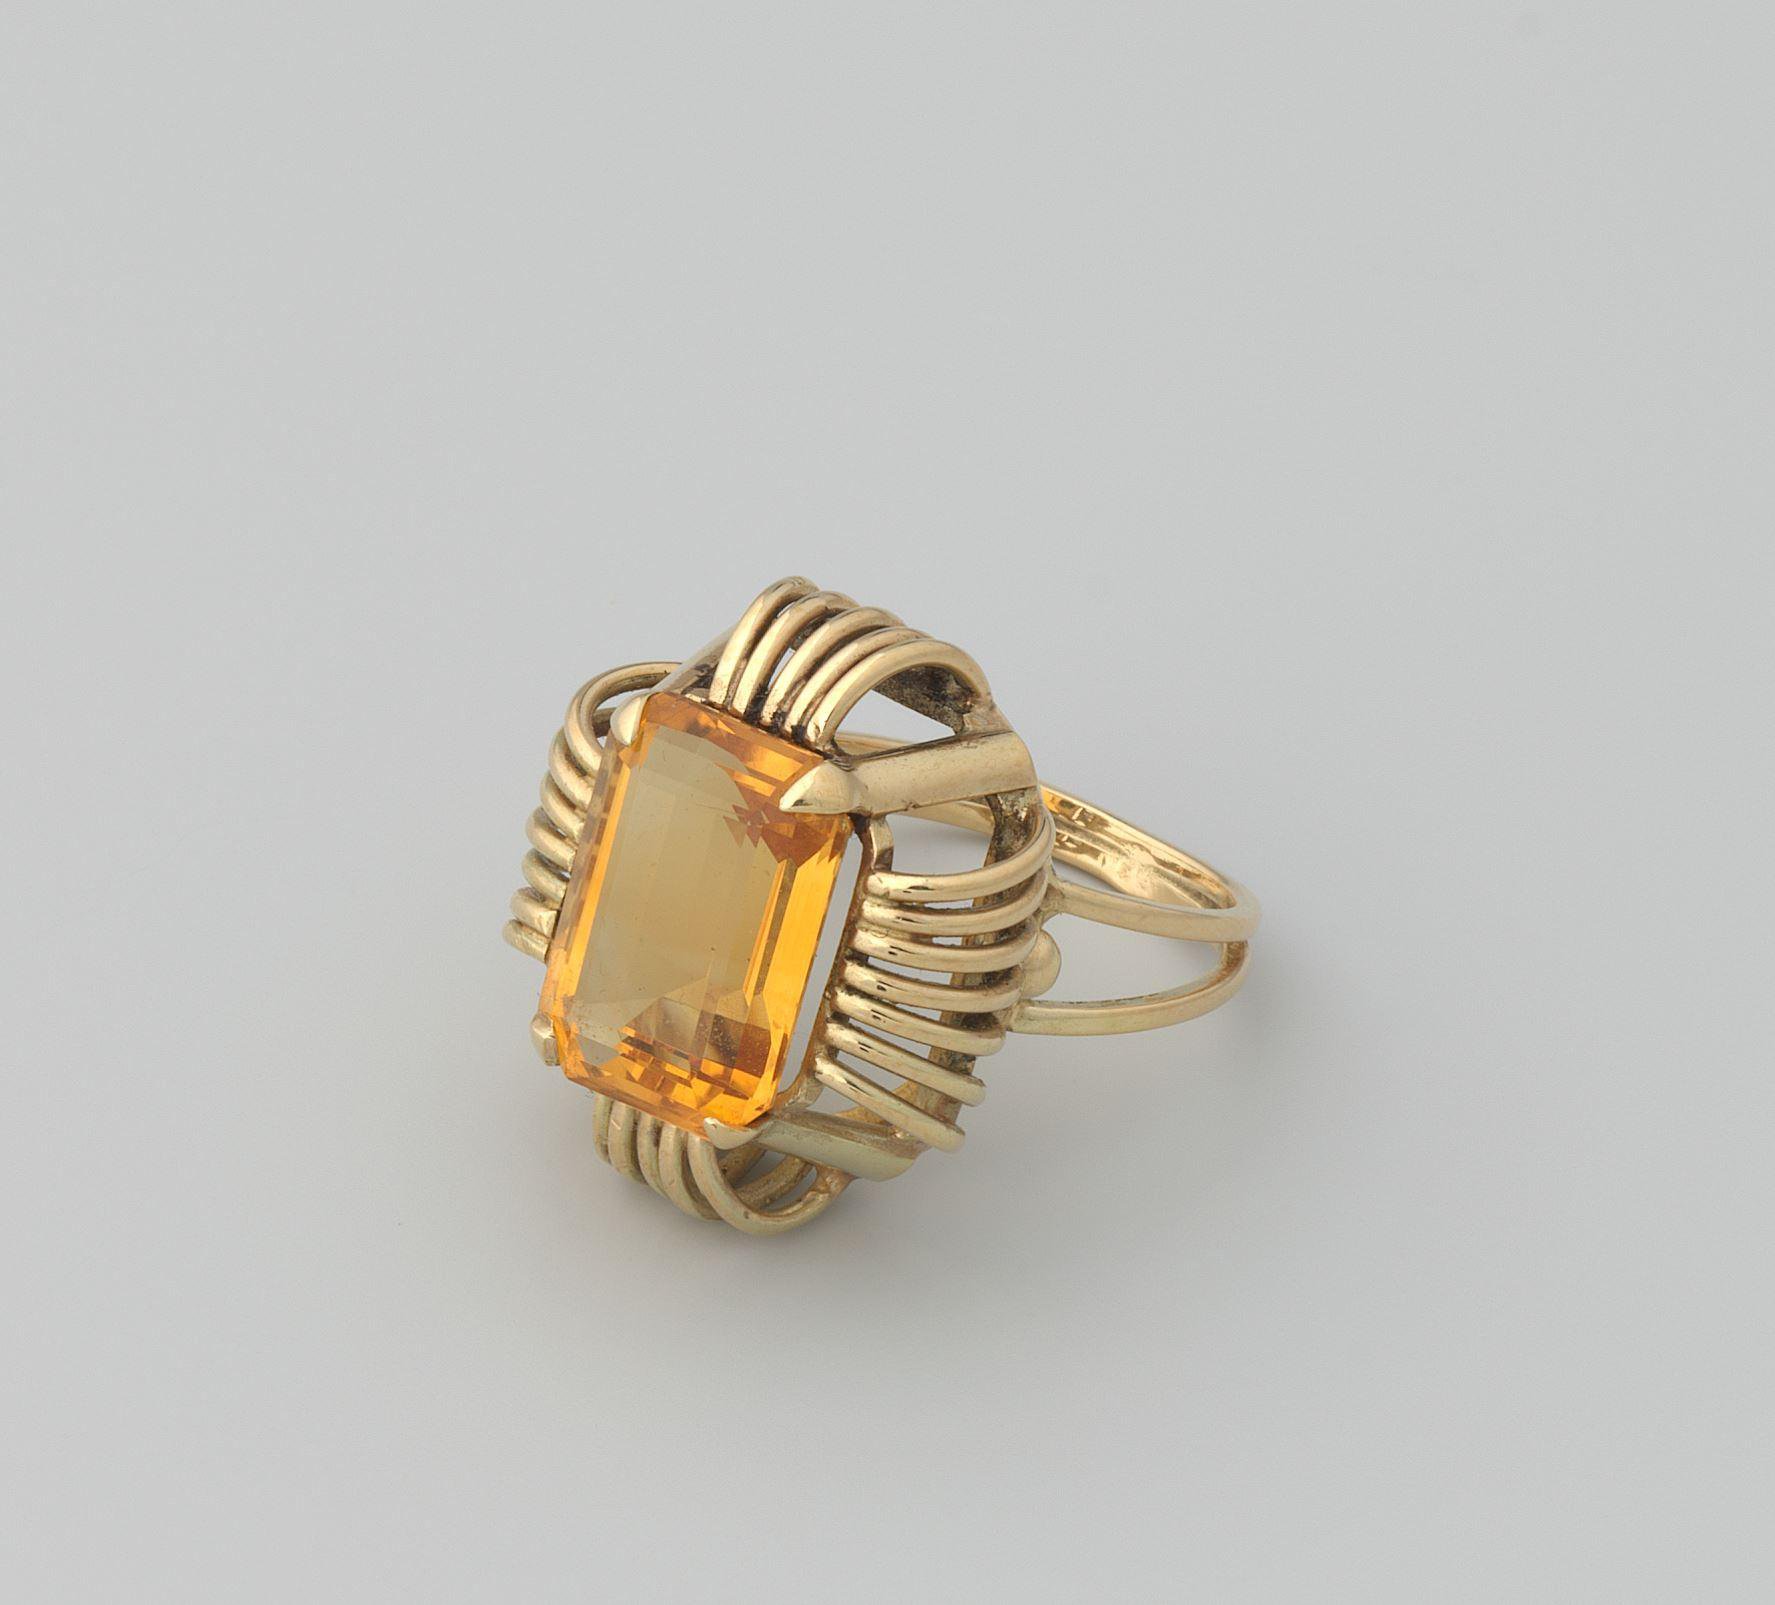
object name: ring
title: Ring van goud met citrien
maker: j.f. van der bruggen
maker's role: goldsmith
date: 1962-1970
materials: gemstone, gold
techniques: grinding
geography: netherlands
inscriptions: maker's mark: ‘FvdB’, alloy mark: ‘eikenblad 585’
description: Ring van goud in spijltjesstijl met citrien en bijbehorende originele rode synthetische steen.